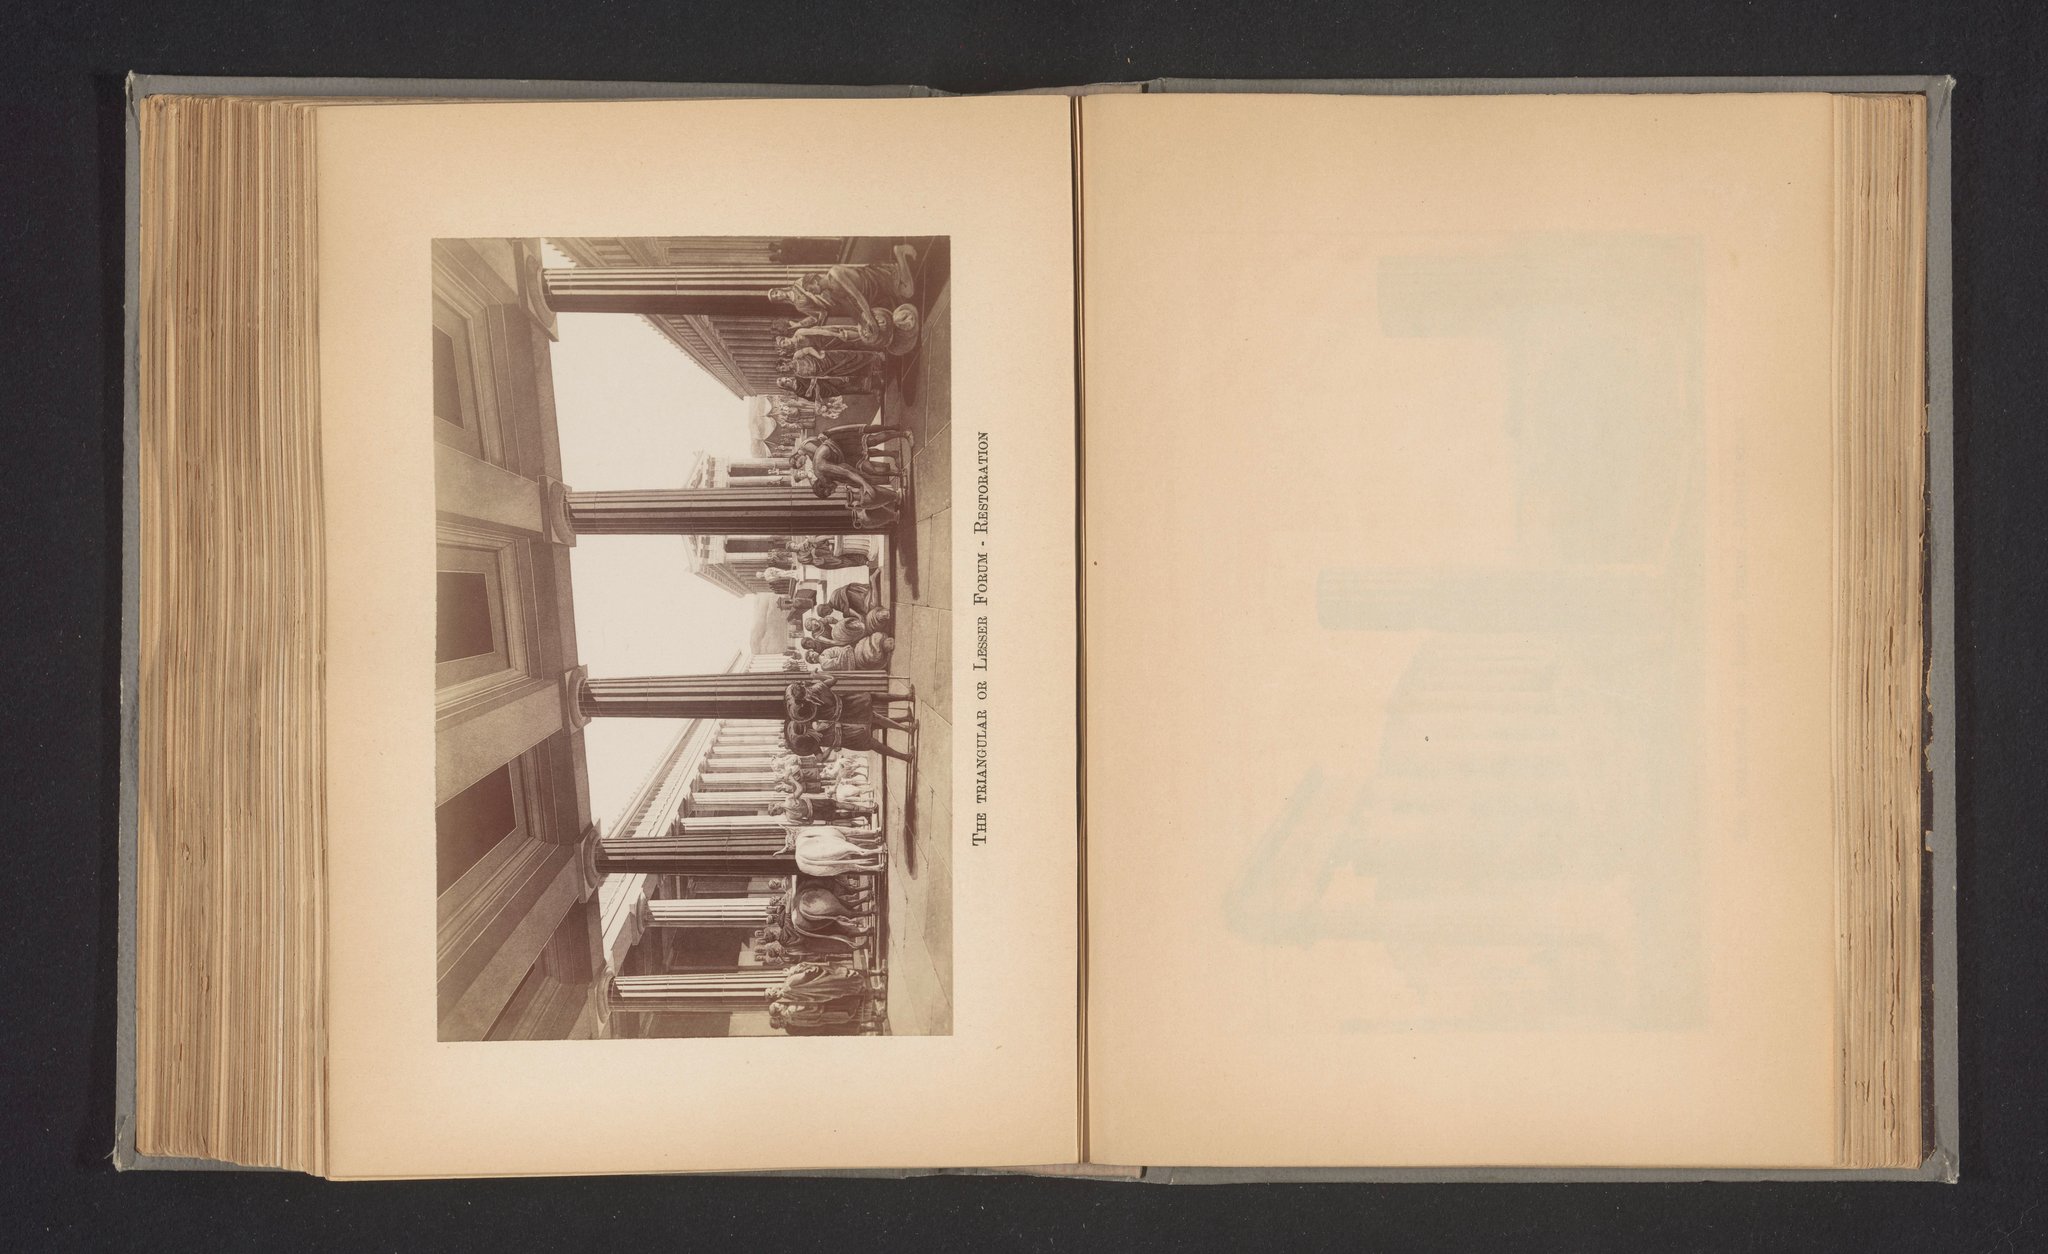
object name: page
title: The triangular or lesser Forum - Restoration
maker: Anonymous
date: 1890-1895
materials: photographic support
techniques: albumen print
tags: civic architecture; edifices; dwellings, pompeii